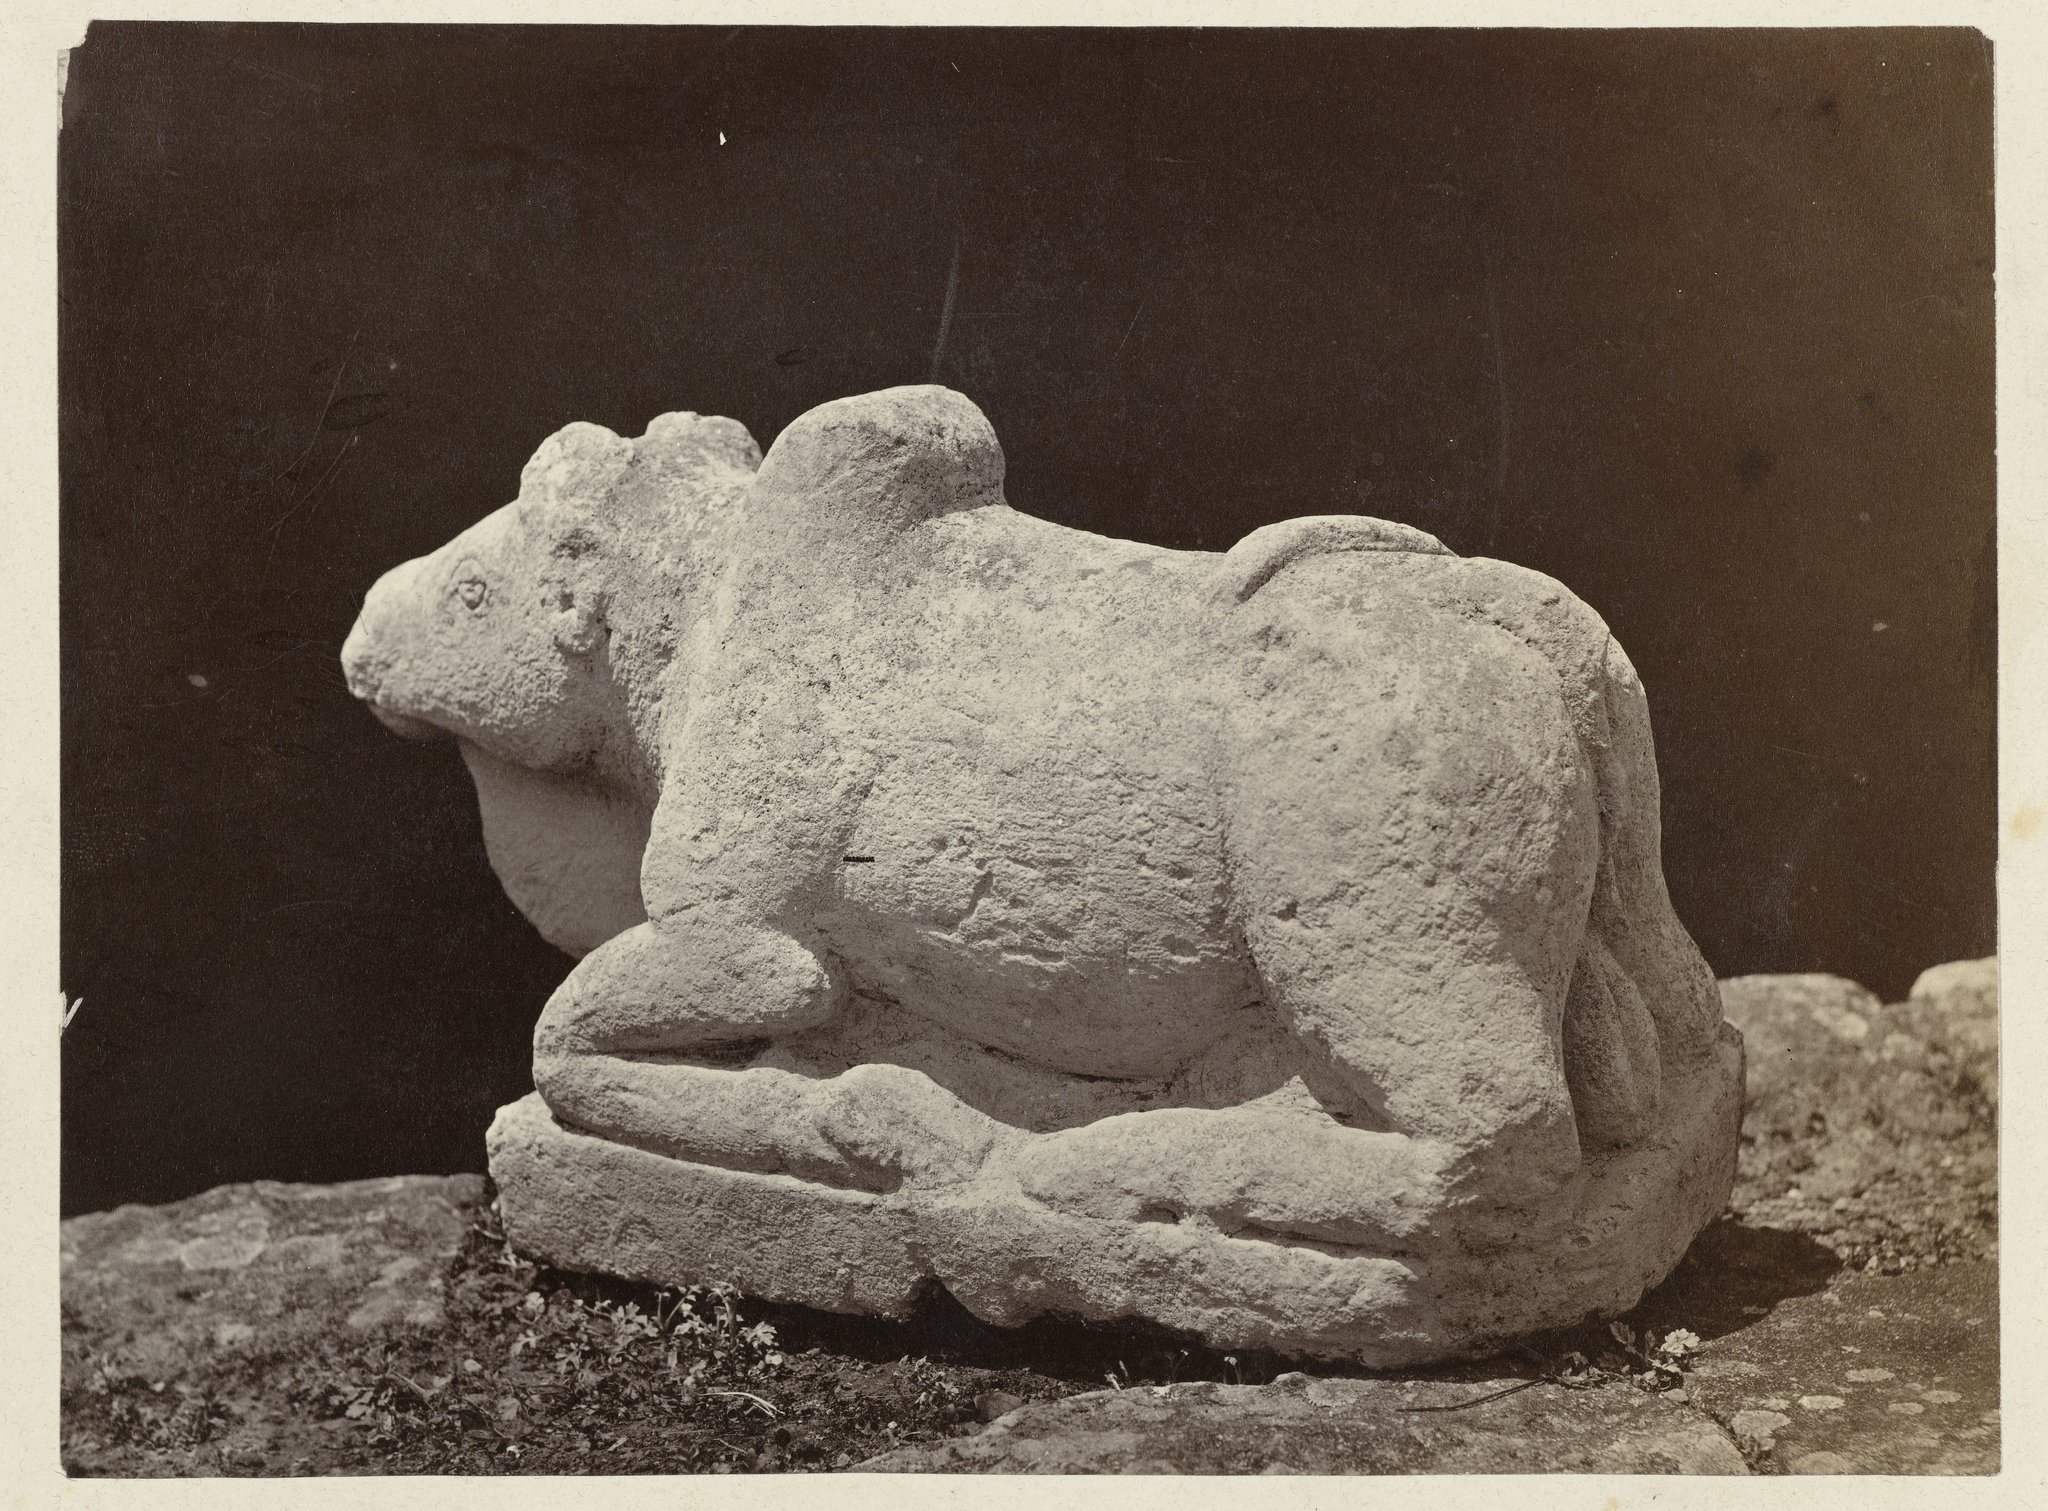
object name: photograph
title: Nandi, the vehicle of Shiva. Dieng Plateau , Wonosobo district , Central Java province , 8th - 9th century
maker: isidore kinsbergen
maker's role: fotograaf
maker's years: 1821-1905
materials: cardboard, paper, photographic support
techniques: albumen print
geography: java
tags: nandi (bull)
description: Nandi, Shiva's vervoersmiddel naar rechts gedraaid.